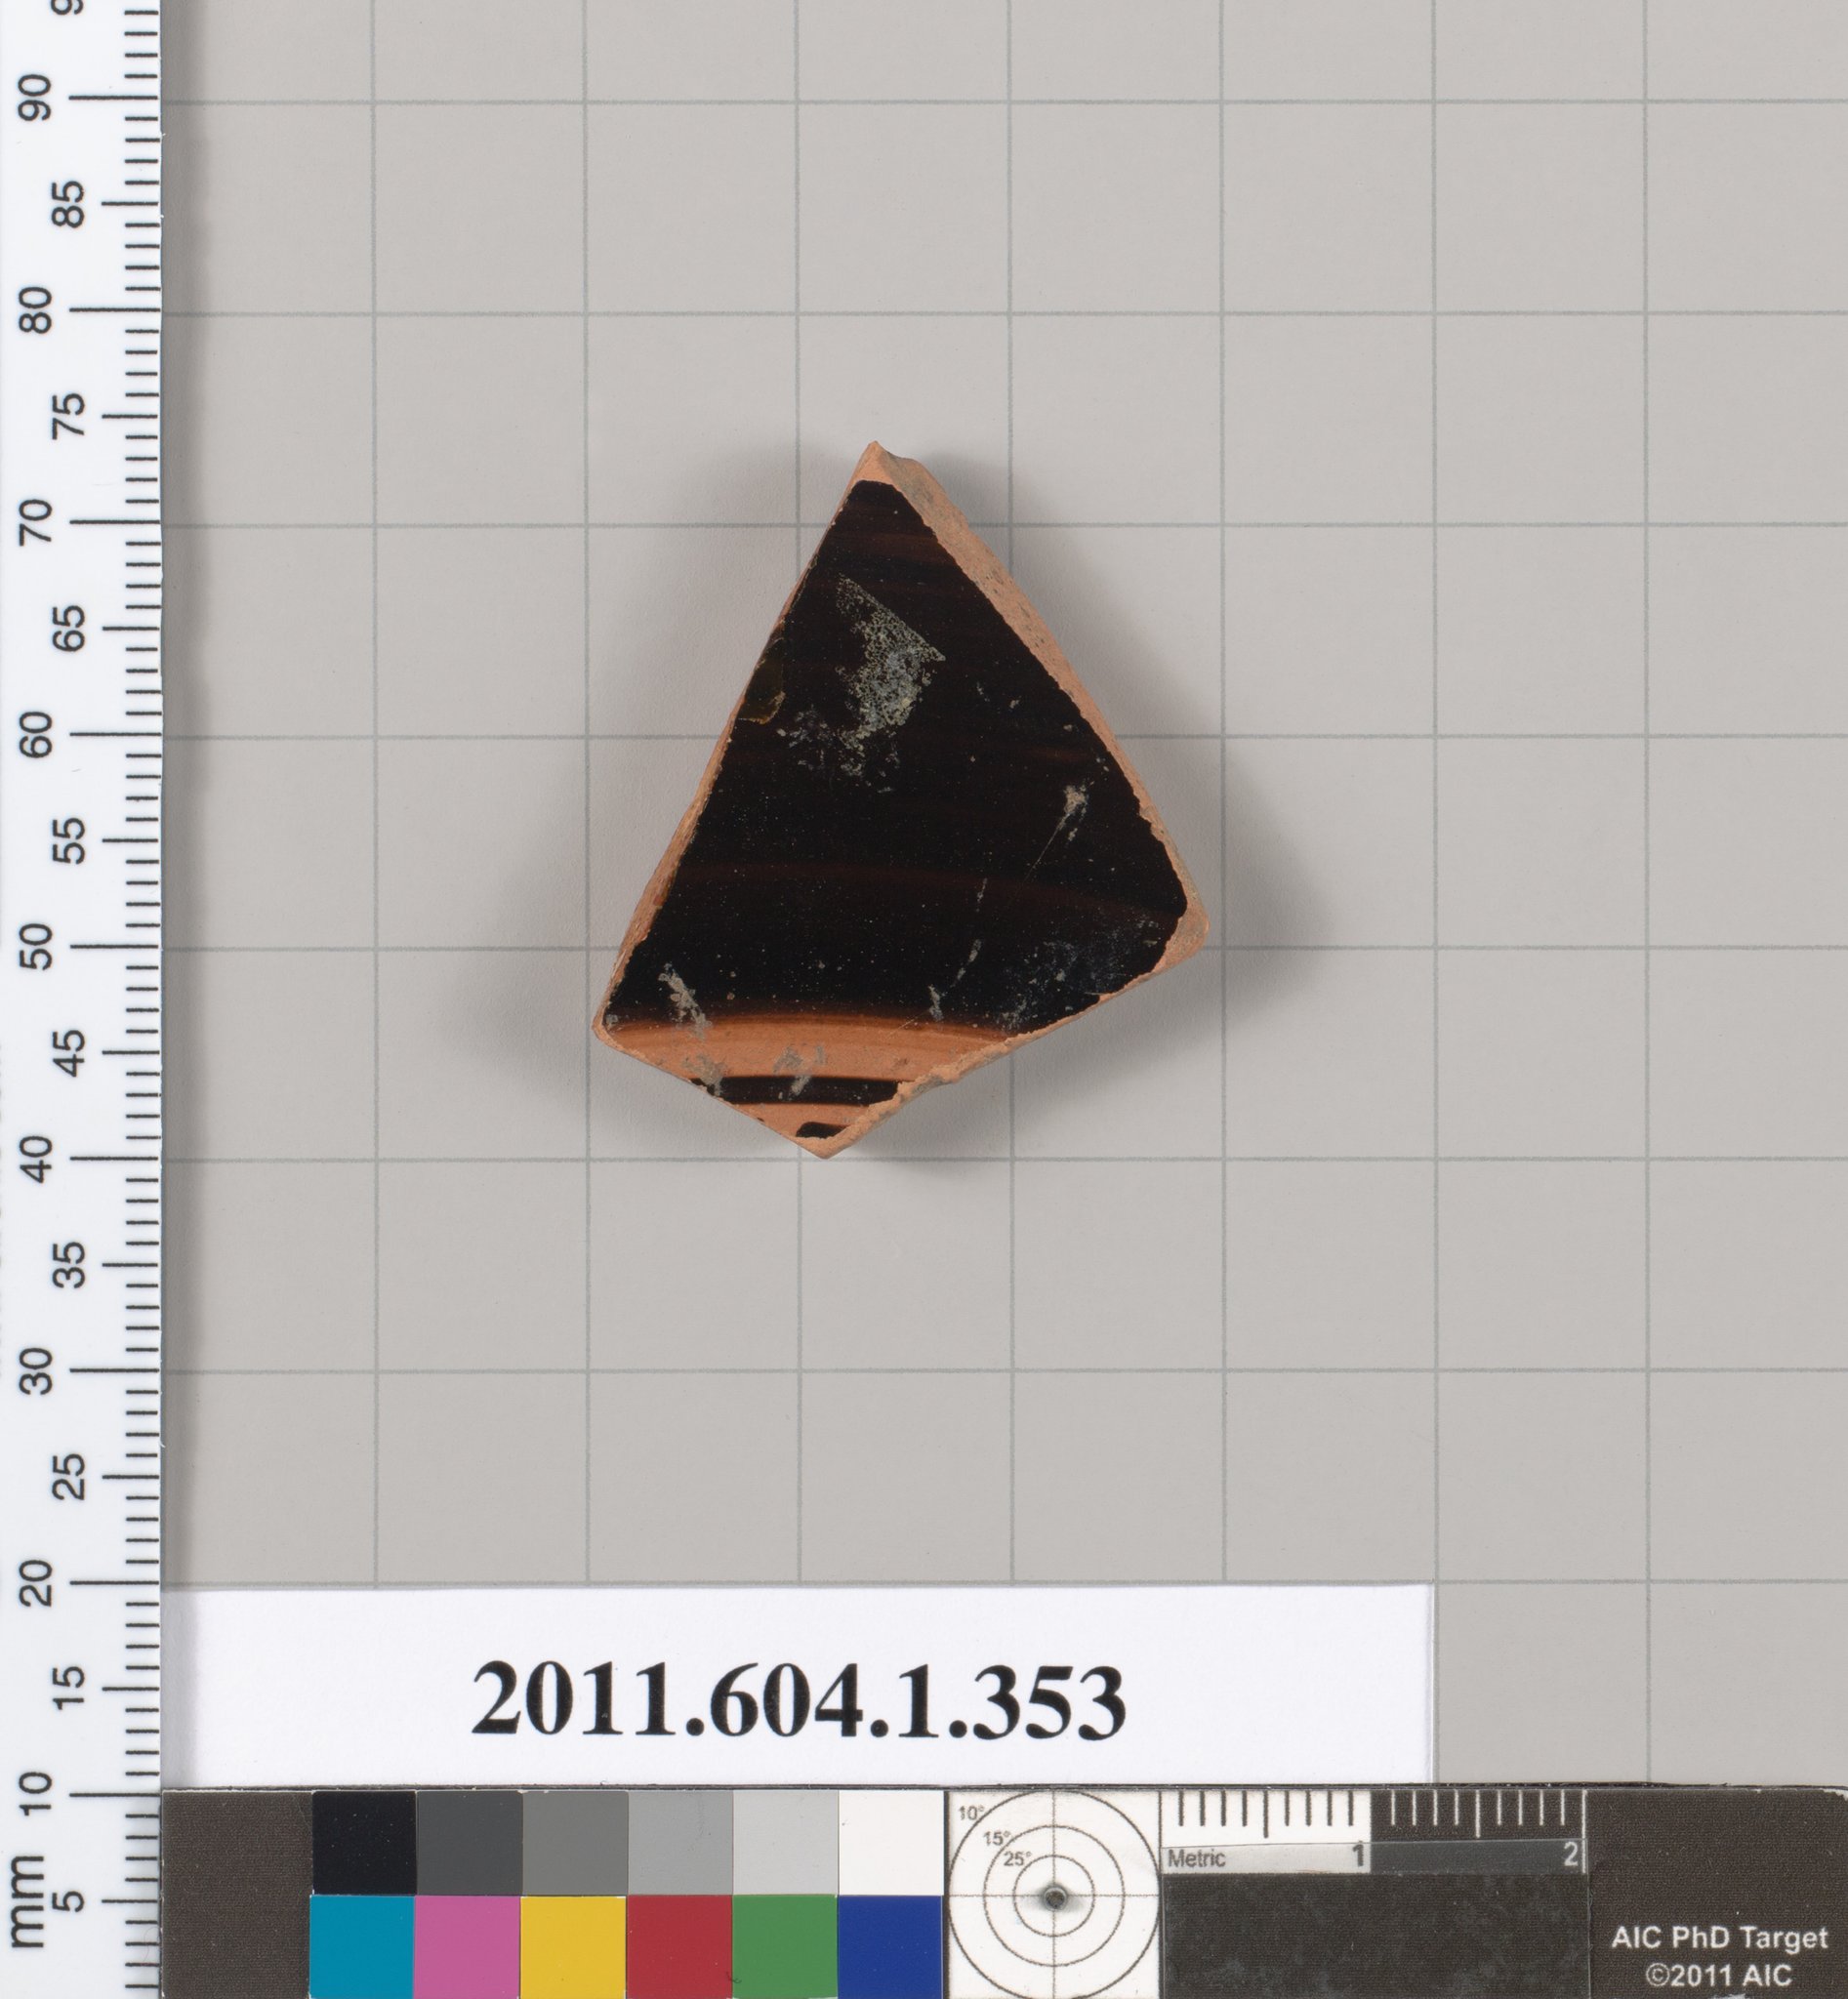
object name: kylix fragment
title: Terracotta fragment of a kylix (drinking cup)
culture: greek, attic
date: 475-451 BCE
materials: terracotta